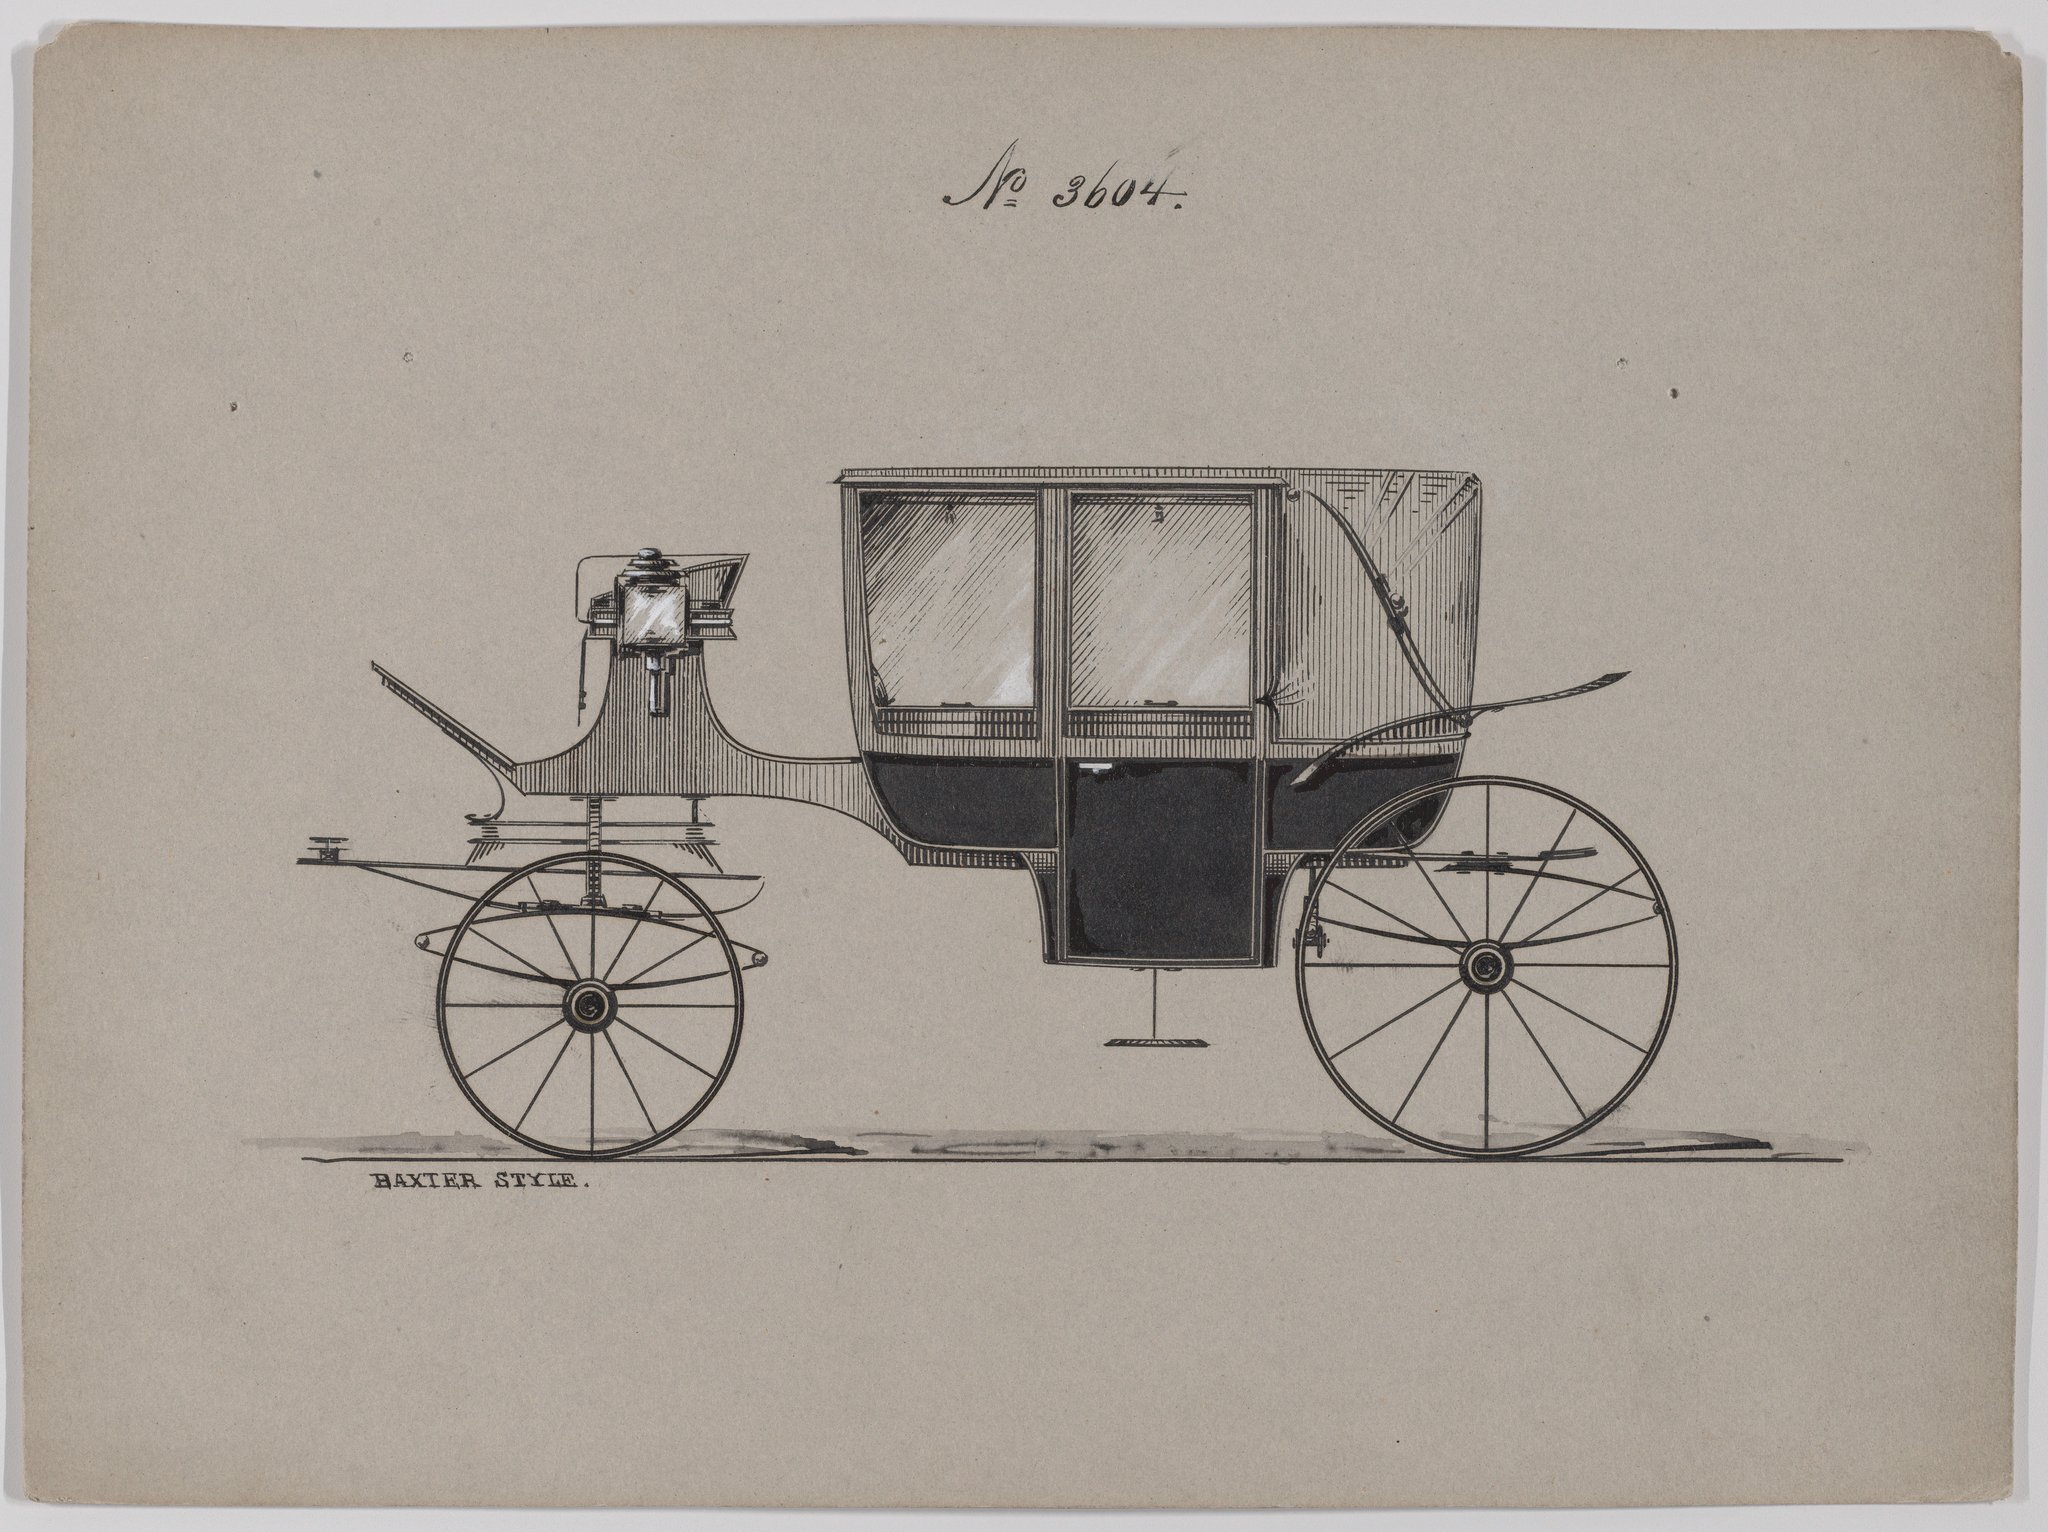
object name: drawing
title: Design for Landau, No. 3604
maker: brewster & co.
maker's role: manufacturer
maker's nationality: american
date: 1880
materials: gum arabic, ink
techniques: pen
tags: carriages